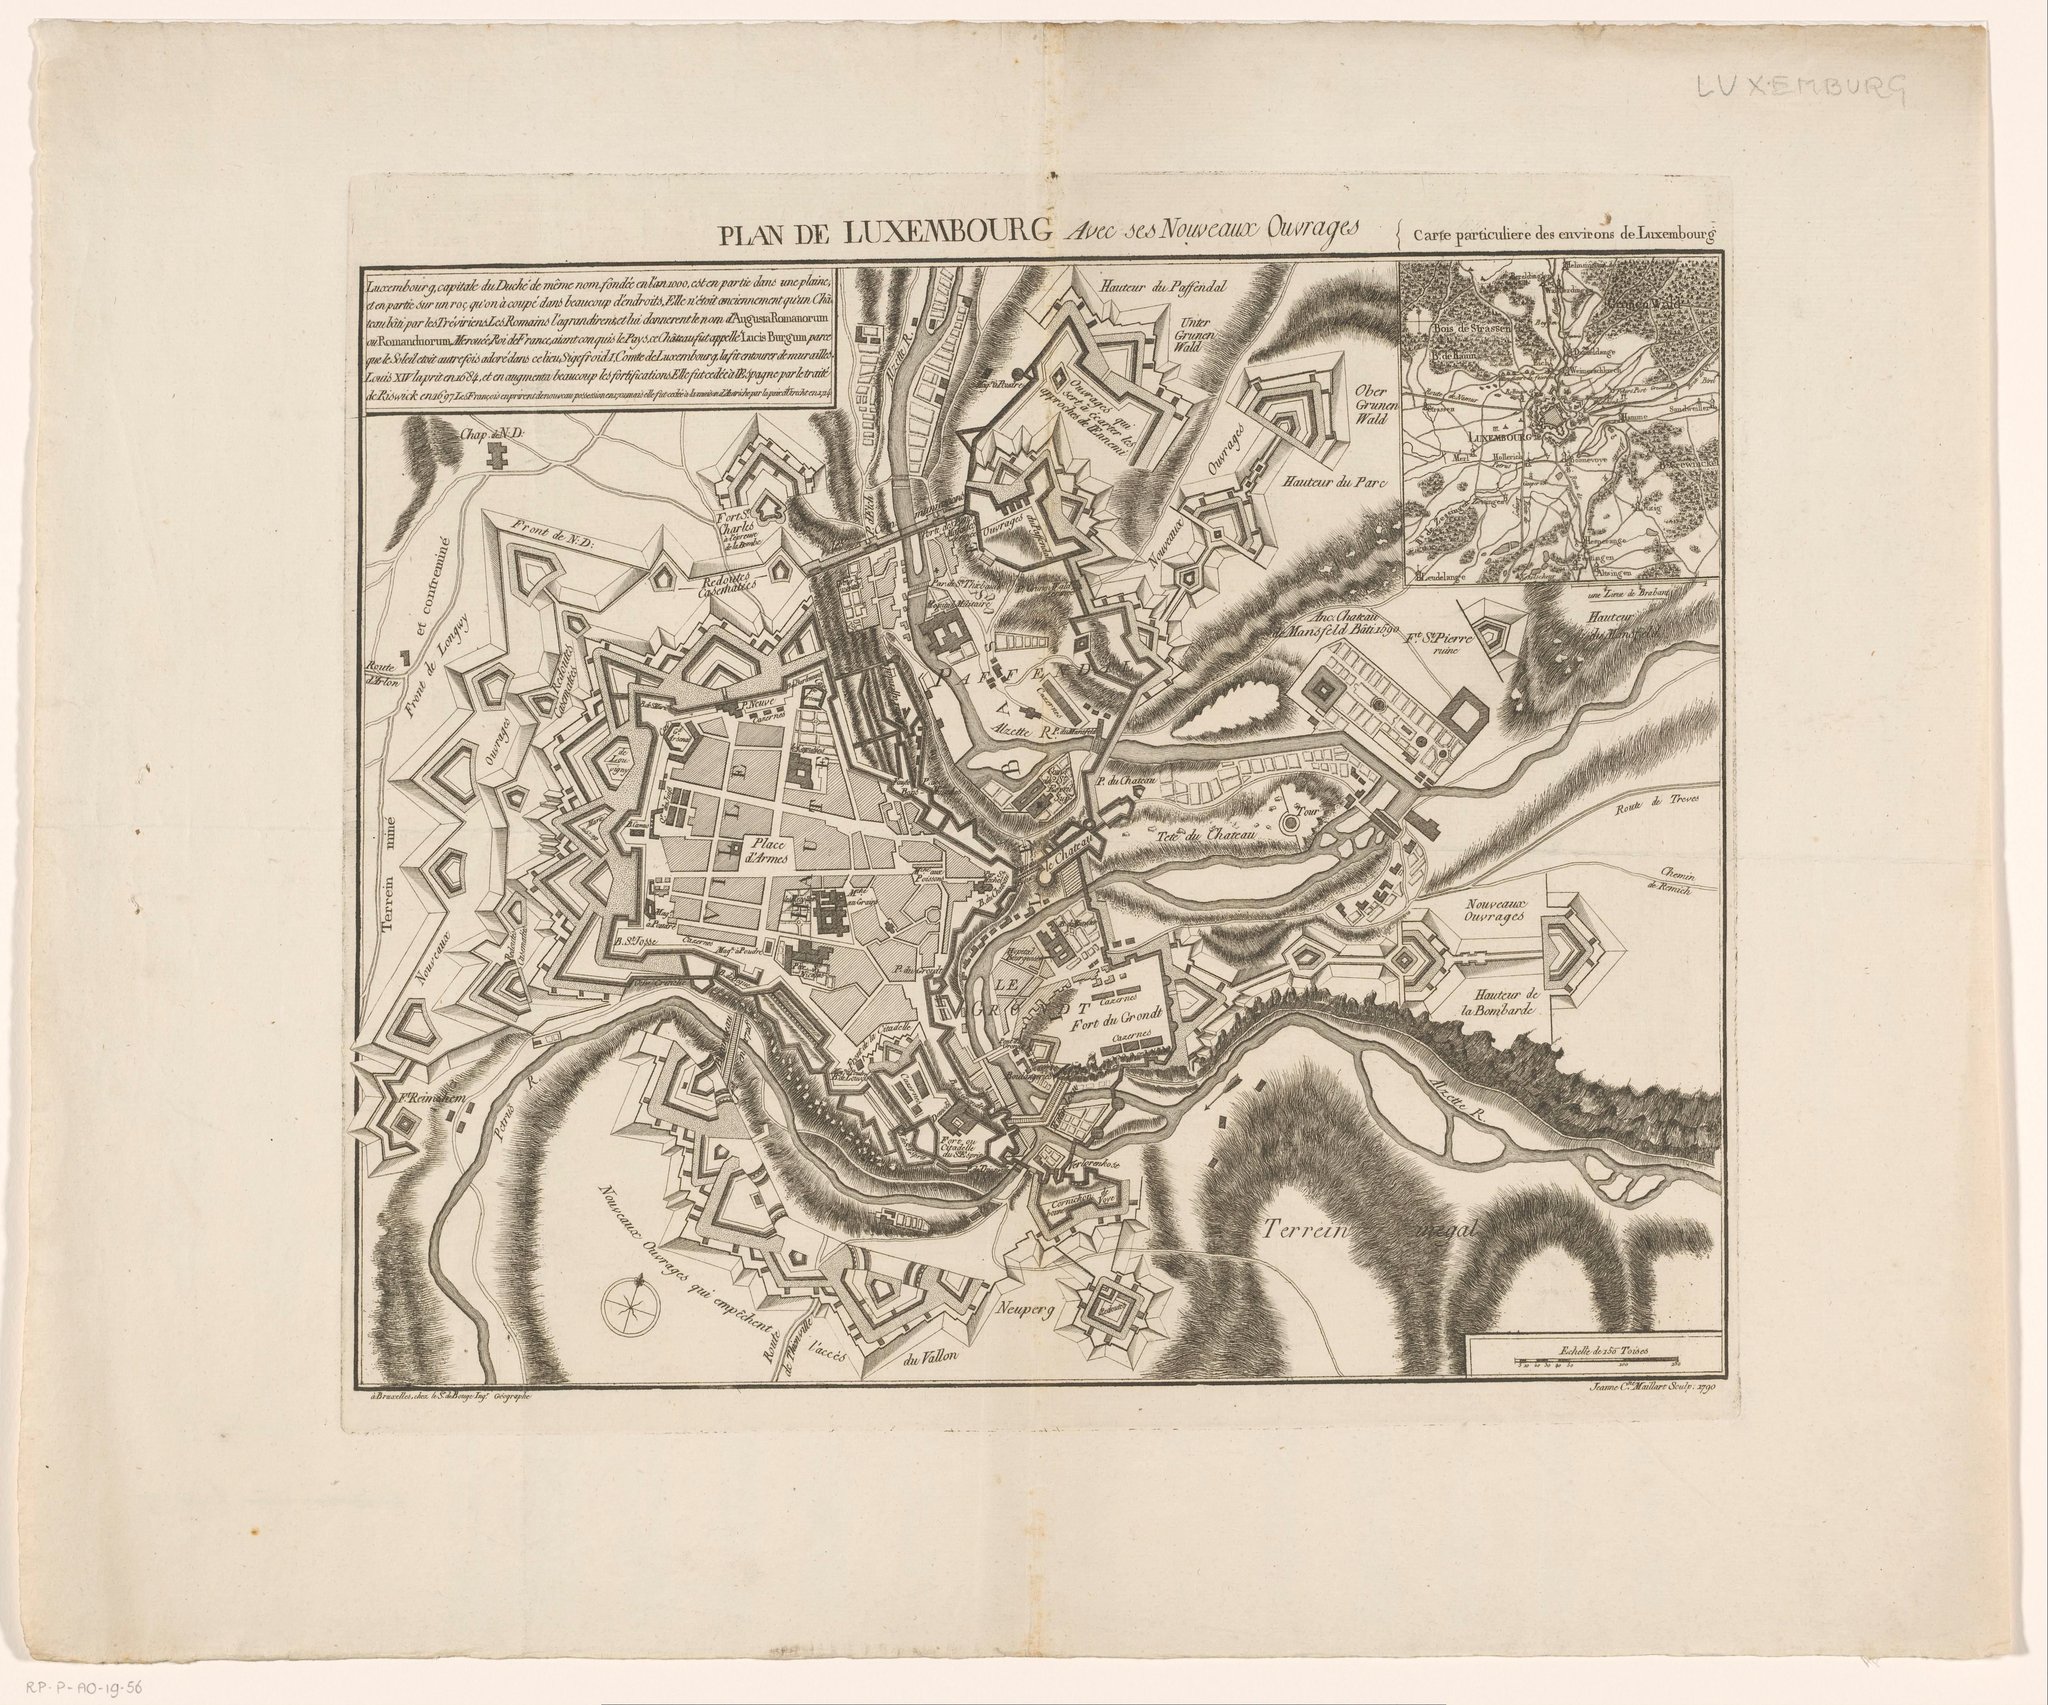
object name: area plan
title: Plan de Luxembourg avec ses nouveaux ouvrages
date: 1790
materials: paper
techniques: engraving, etching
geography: brussels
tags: maps of separate countries or regions, fortified city, maps of cities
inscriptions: collector's mark: Lugt 19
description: Plattegrond van Luxemburg. De titel boven de plattegrond. Linksboven een kader met Franse tekst over de stad. Rechtsonder een kader met schaalstok: Echelle de 150 Toises. Rechtsboven een inzet met kaart van de omgeving van Luxemburg, daaronder een bijbehorende schaalstok: Une Lieue de Brabant.